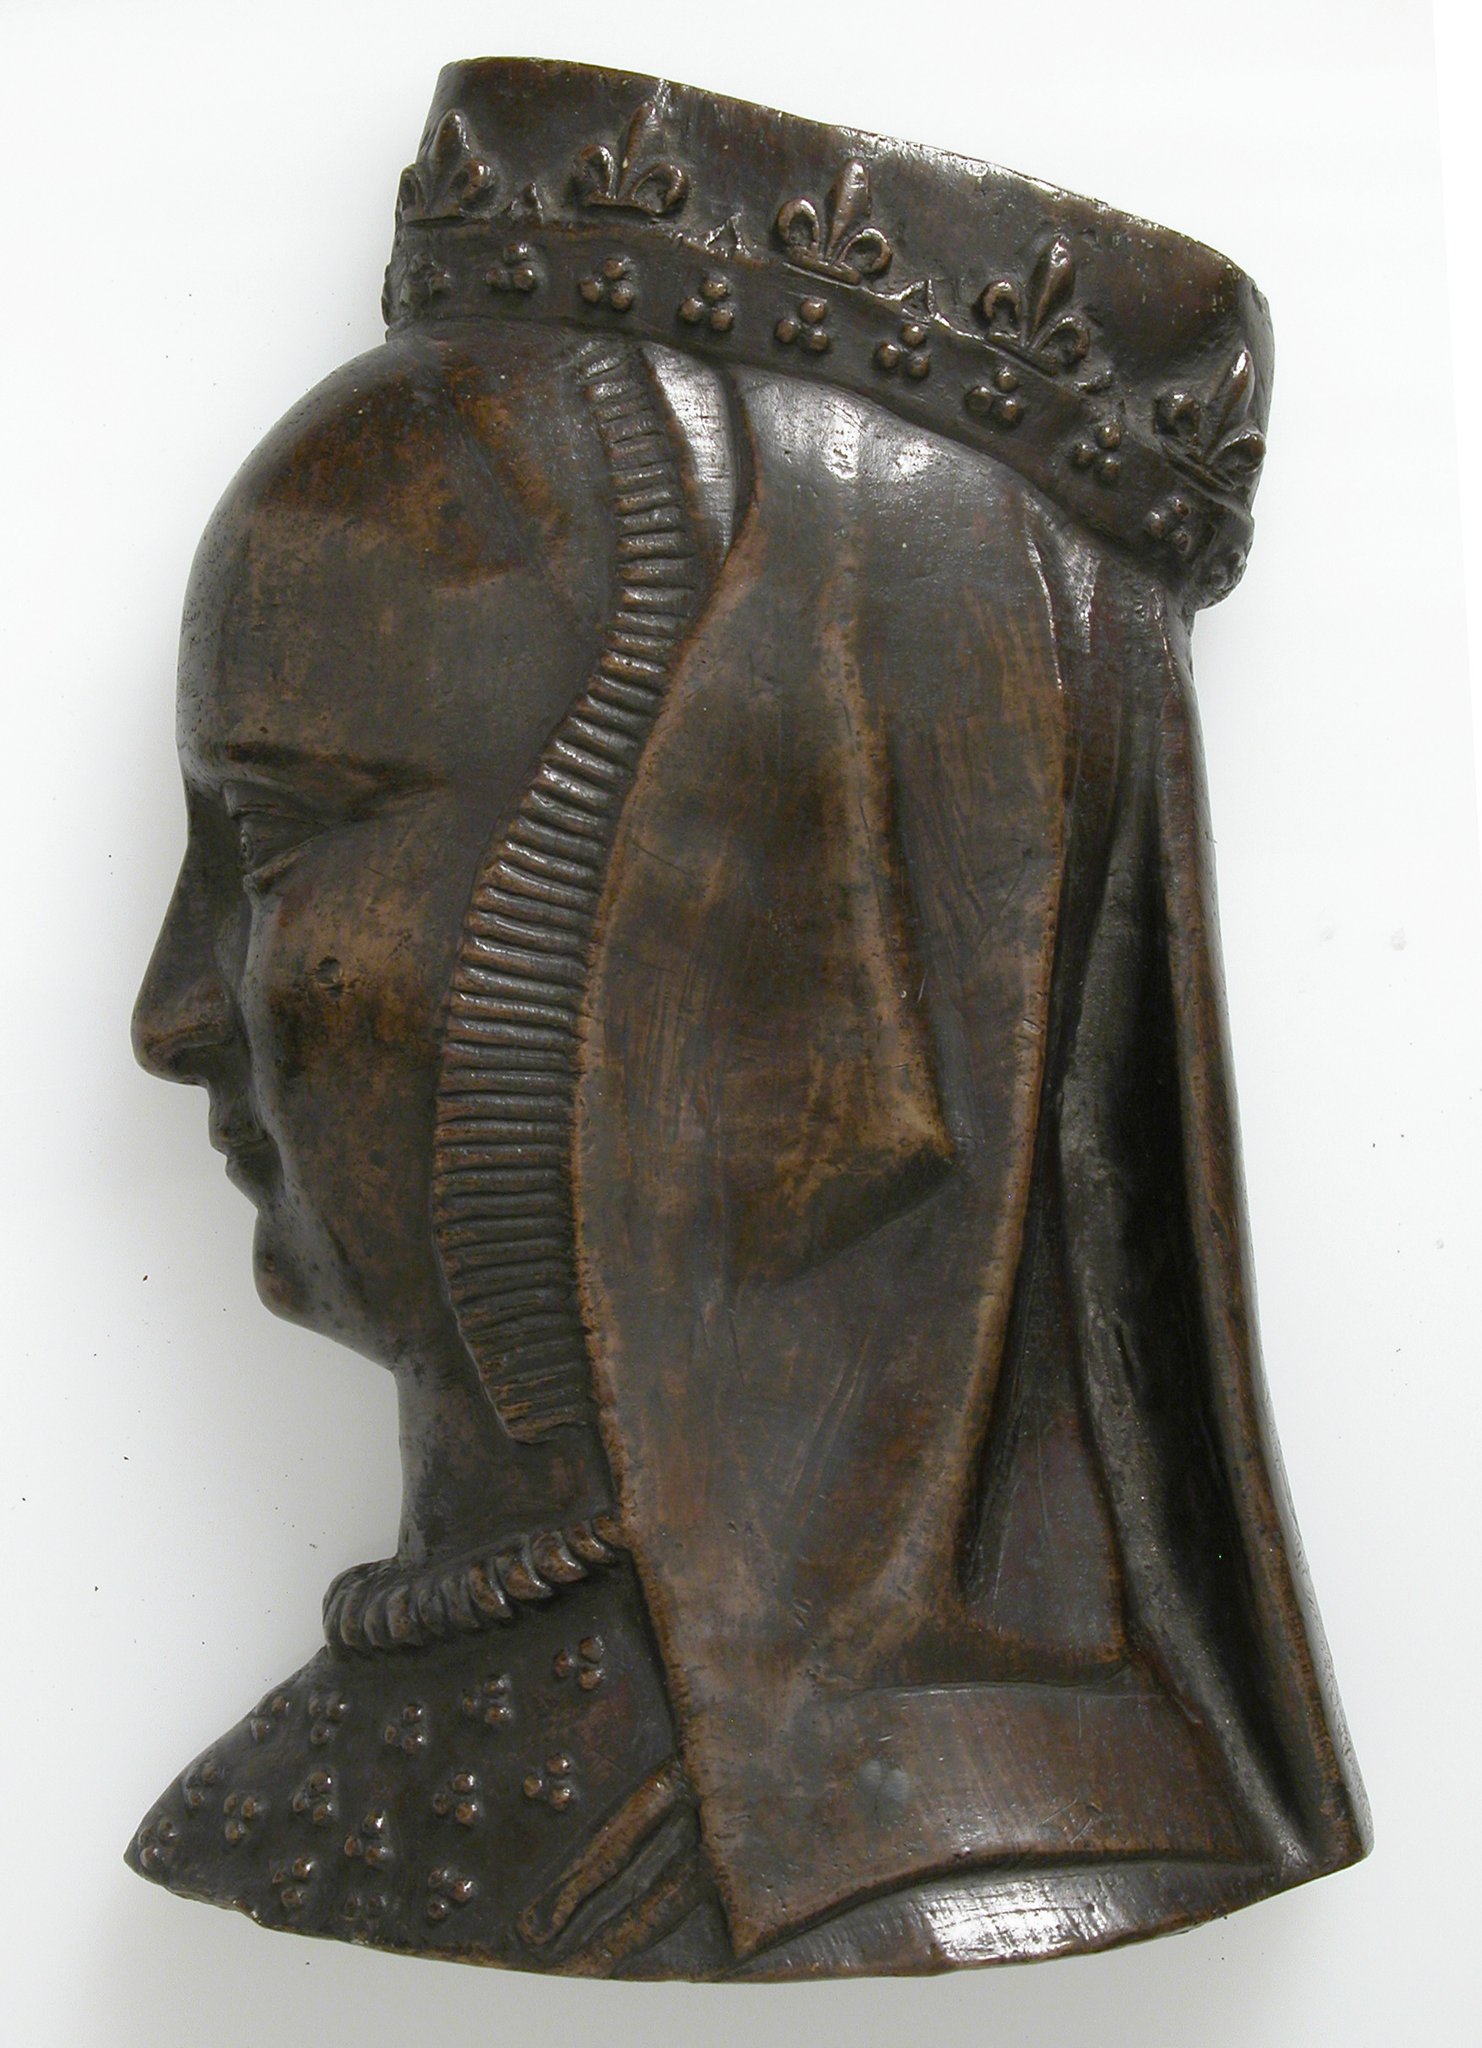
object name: plaque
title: Plaque, Anne of Brittany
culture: french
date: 1401-1500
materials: copper alloy